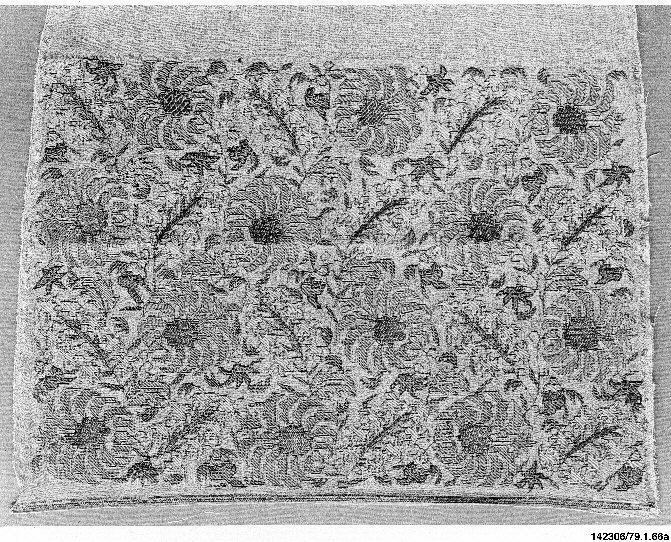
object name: towel end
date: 1701-1900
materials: linen, metal thread, silk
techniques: embroidery, weave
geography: turkey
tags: flowers